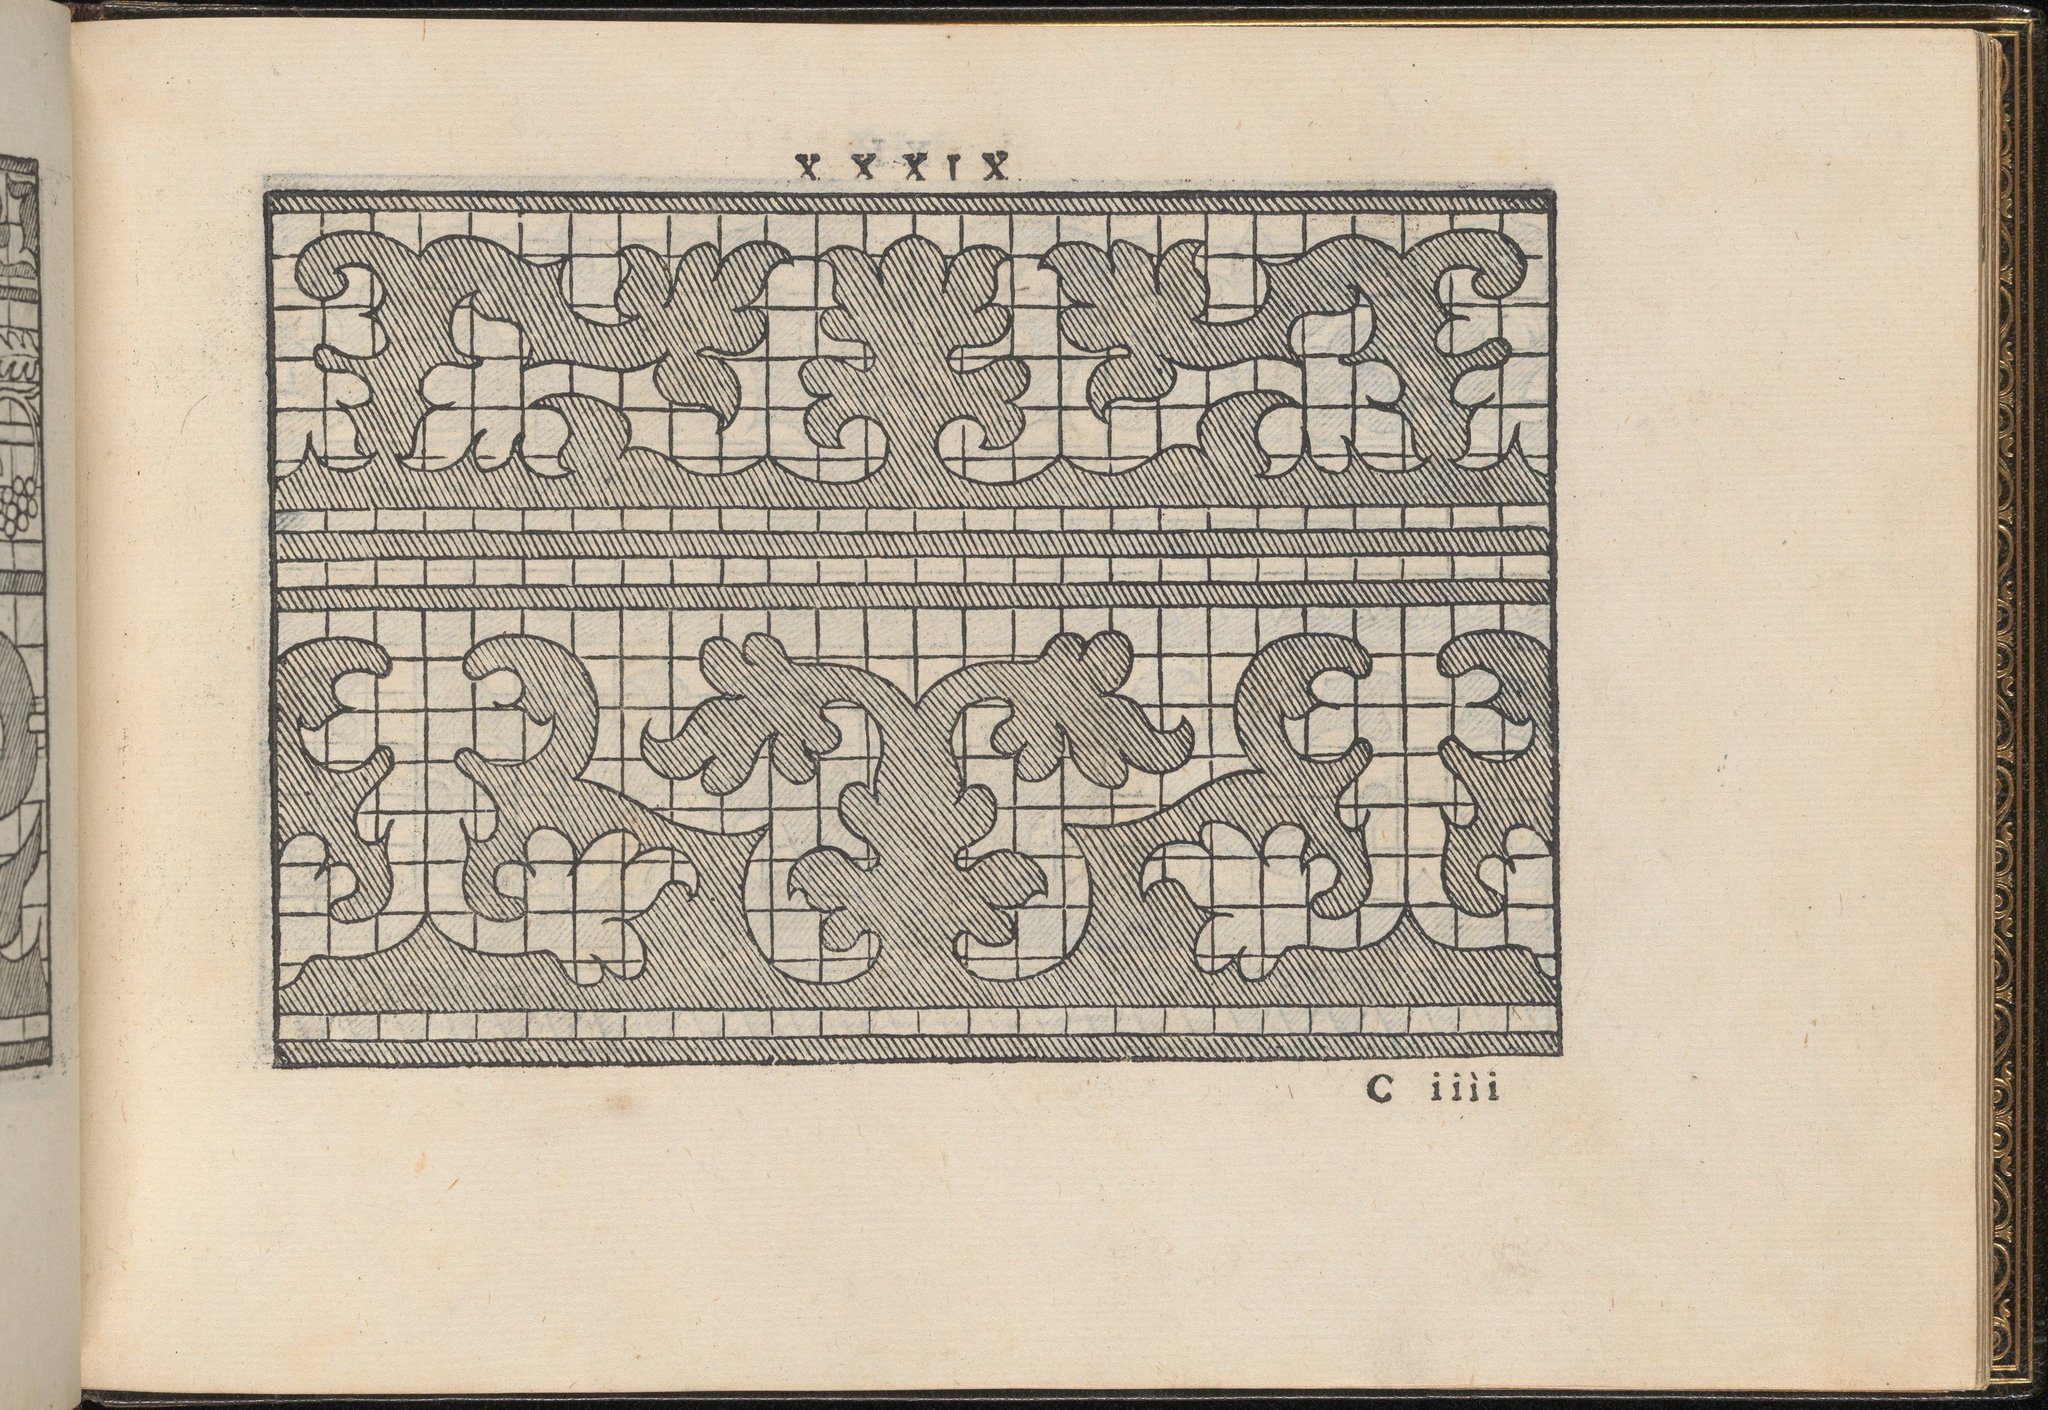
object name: book print ornament architecture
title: La Vera Perfettione del Disegno di varie sorti di recami, page 20 (recto)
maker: giovanni ostaus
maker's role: publisher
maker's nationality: italian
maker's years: 1507-1607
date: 1567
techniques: woodcut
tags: ornament